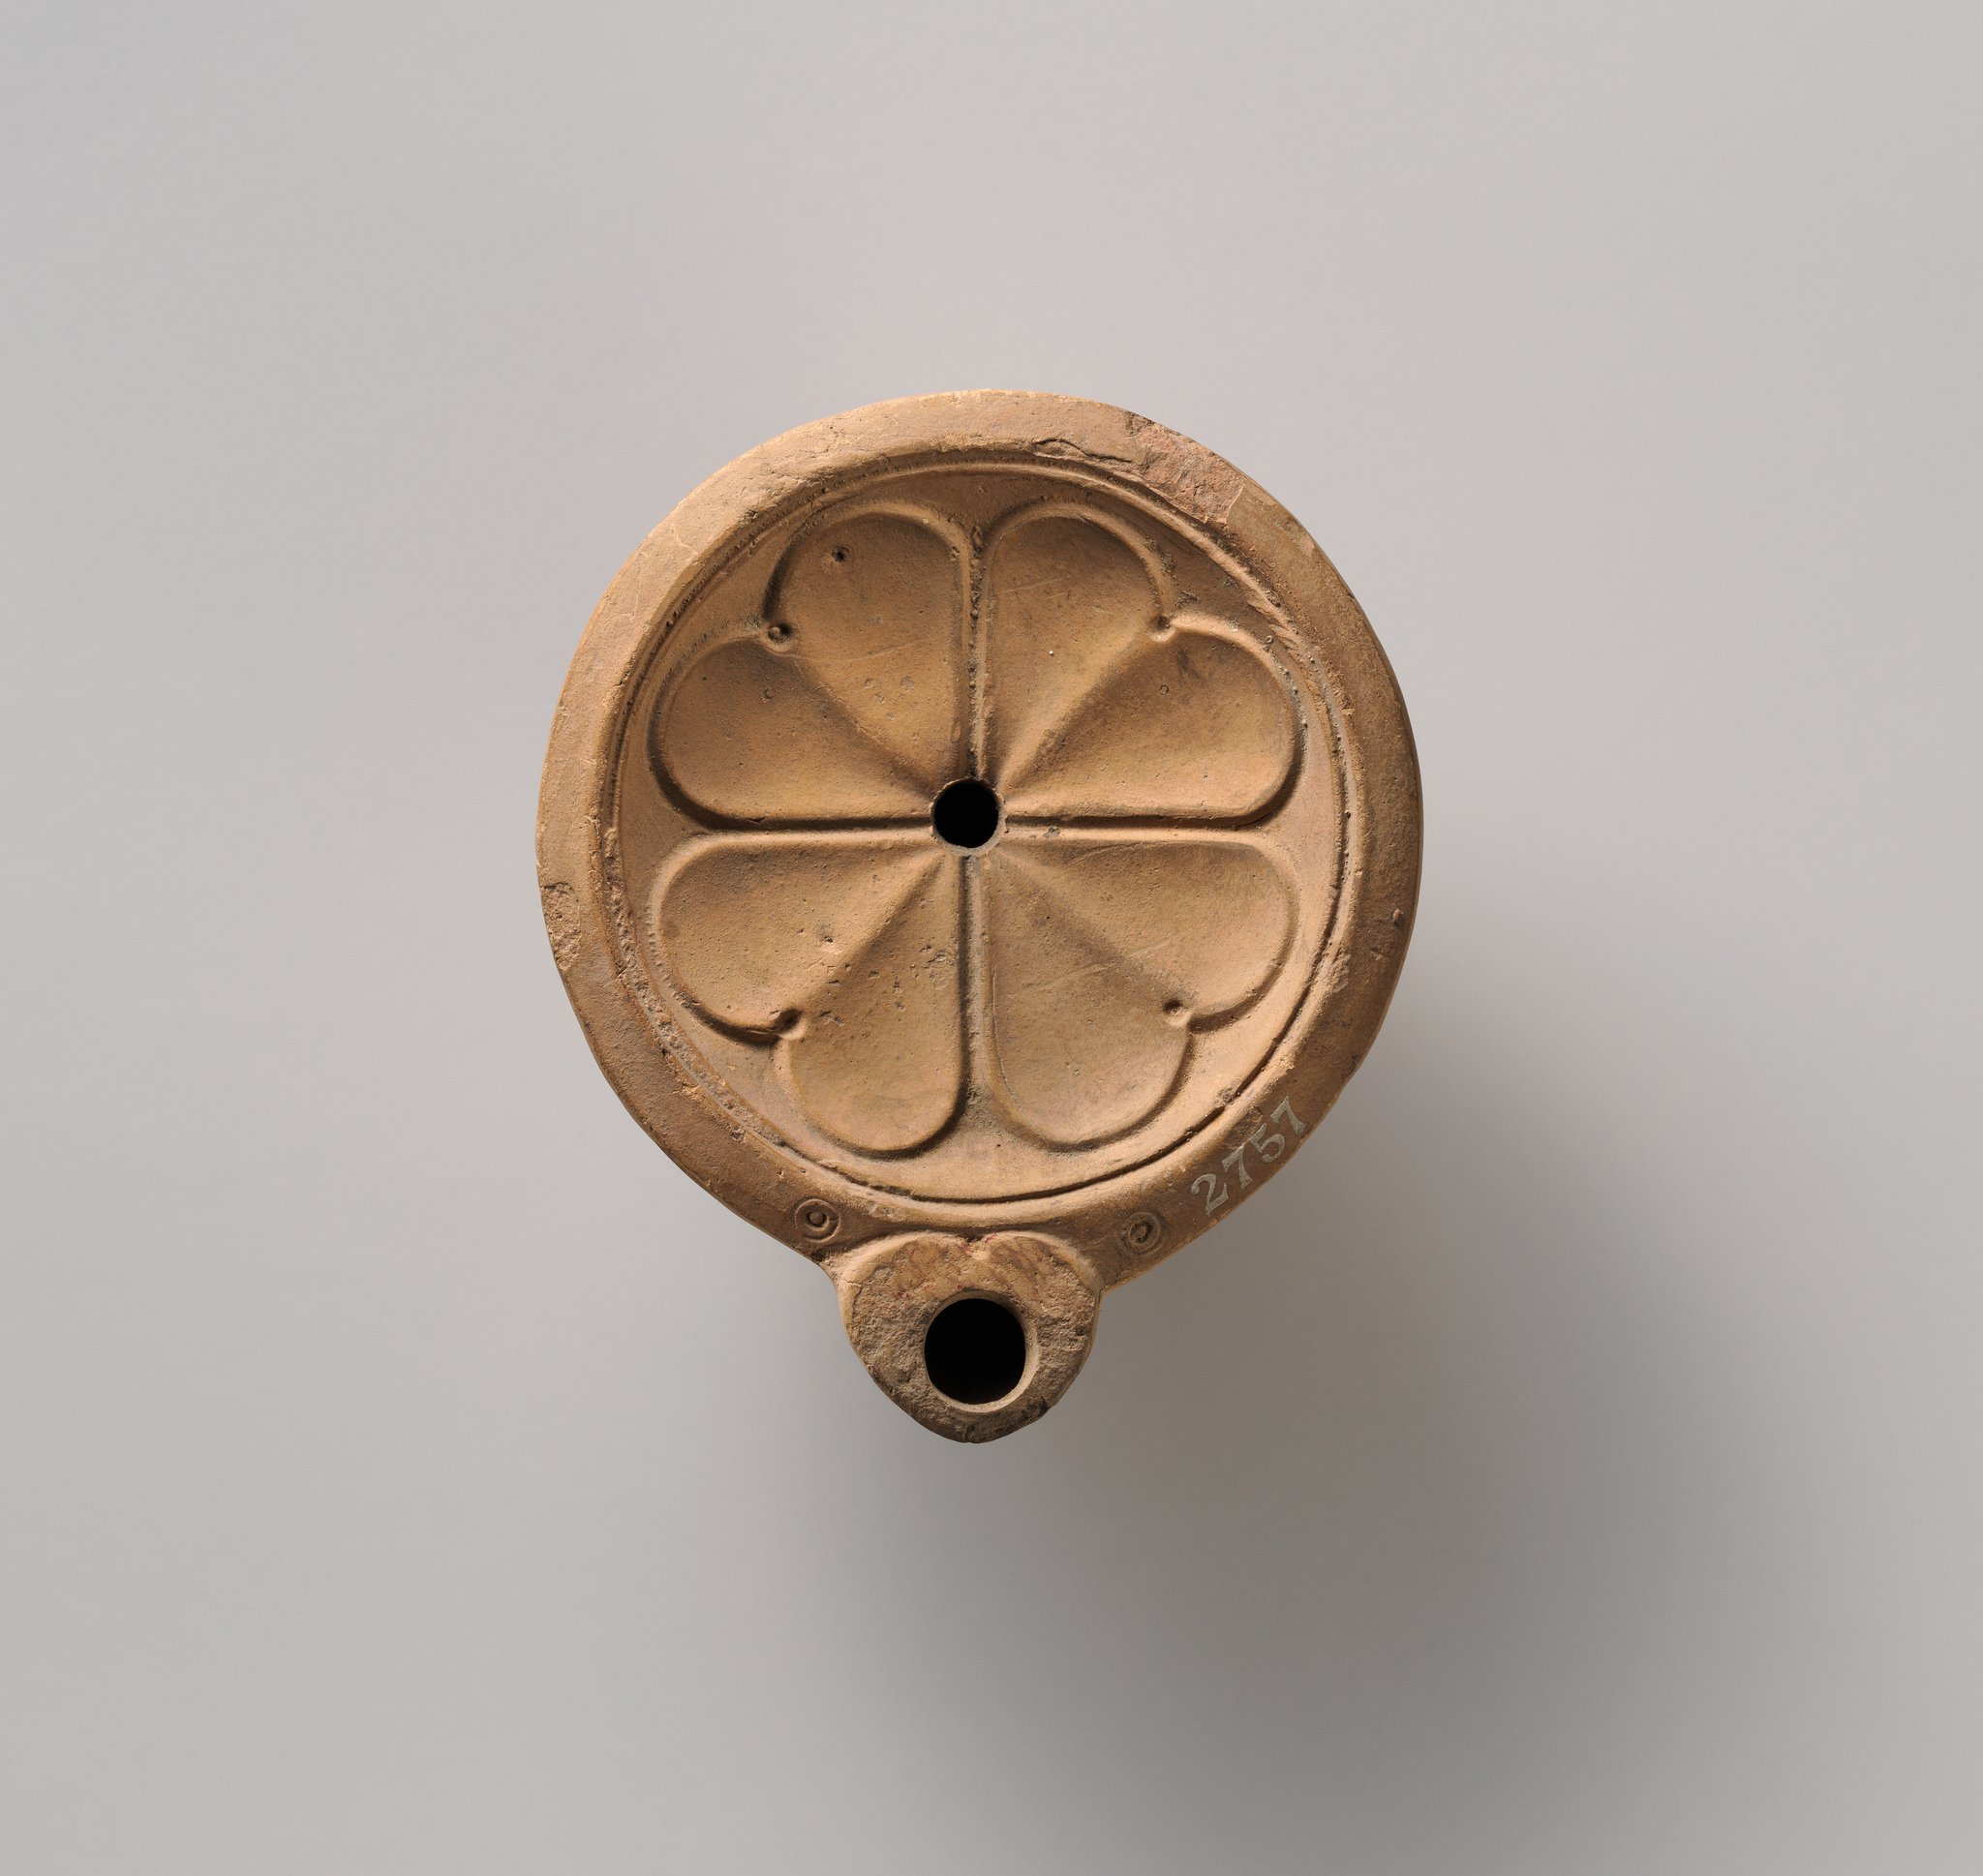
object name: lamp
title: Terracotta oil lamp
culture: roman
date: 101-200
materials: terracotta